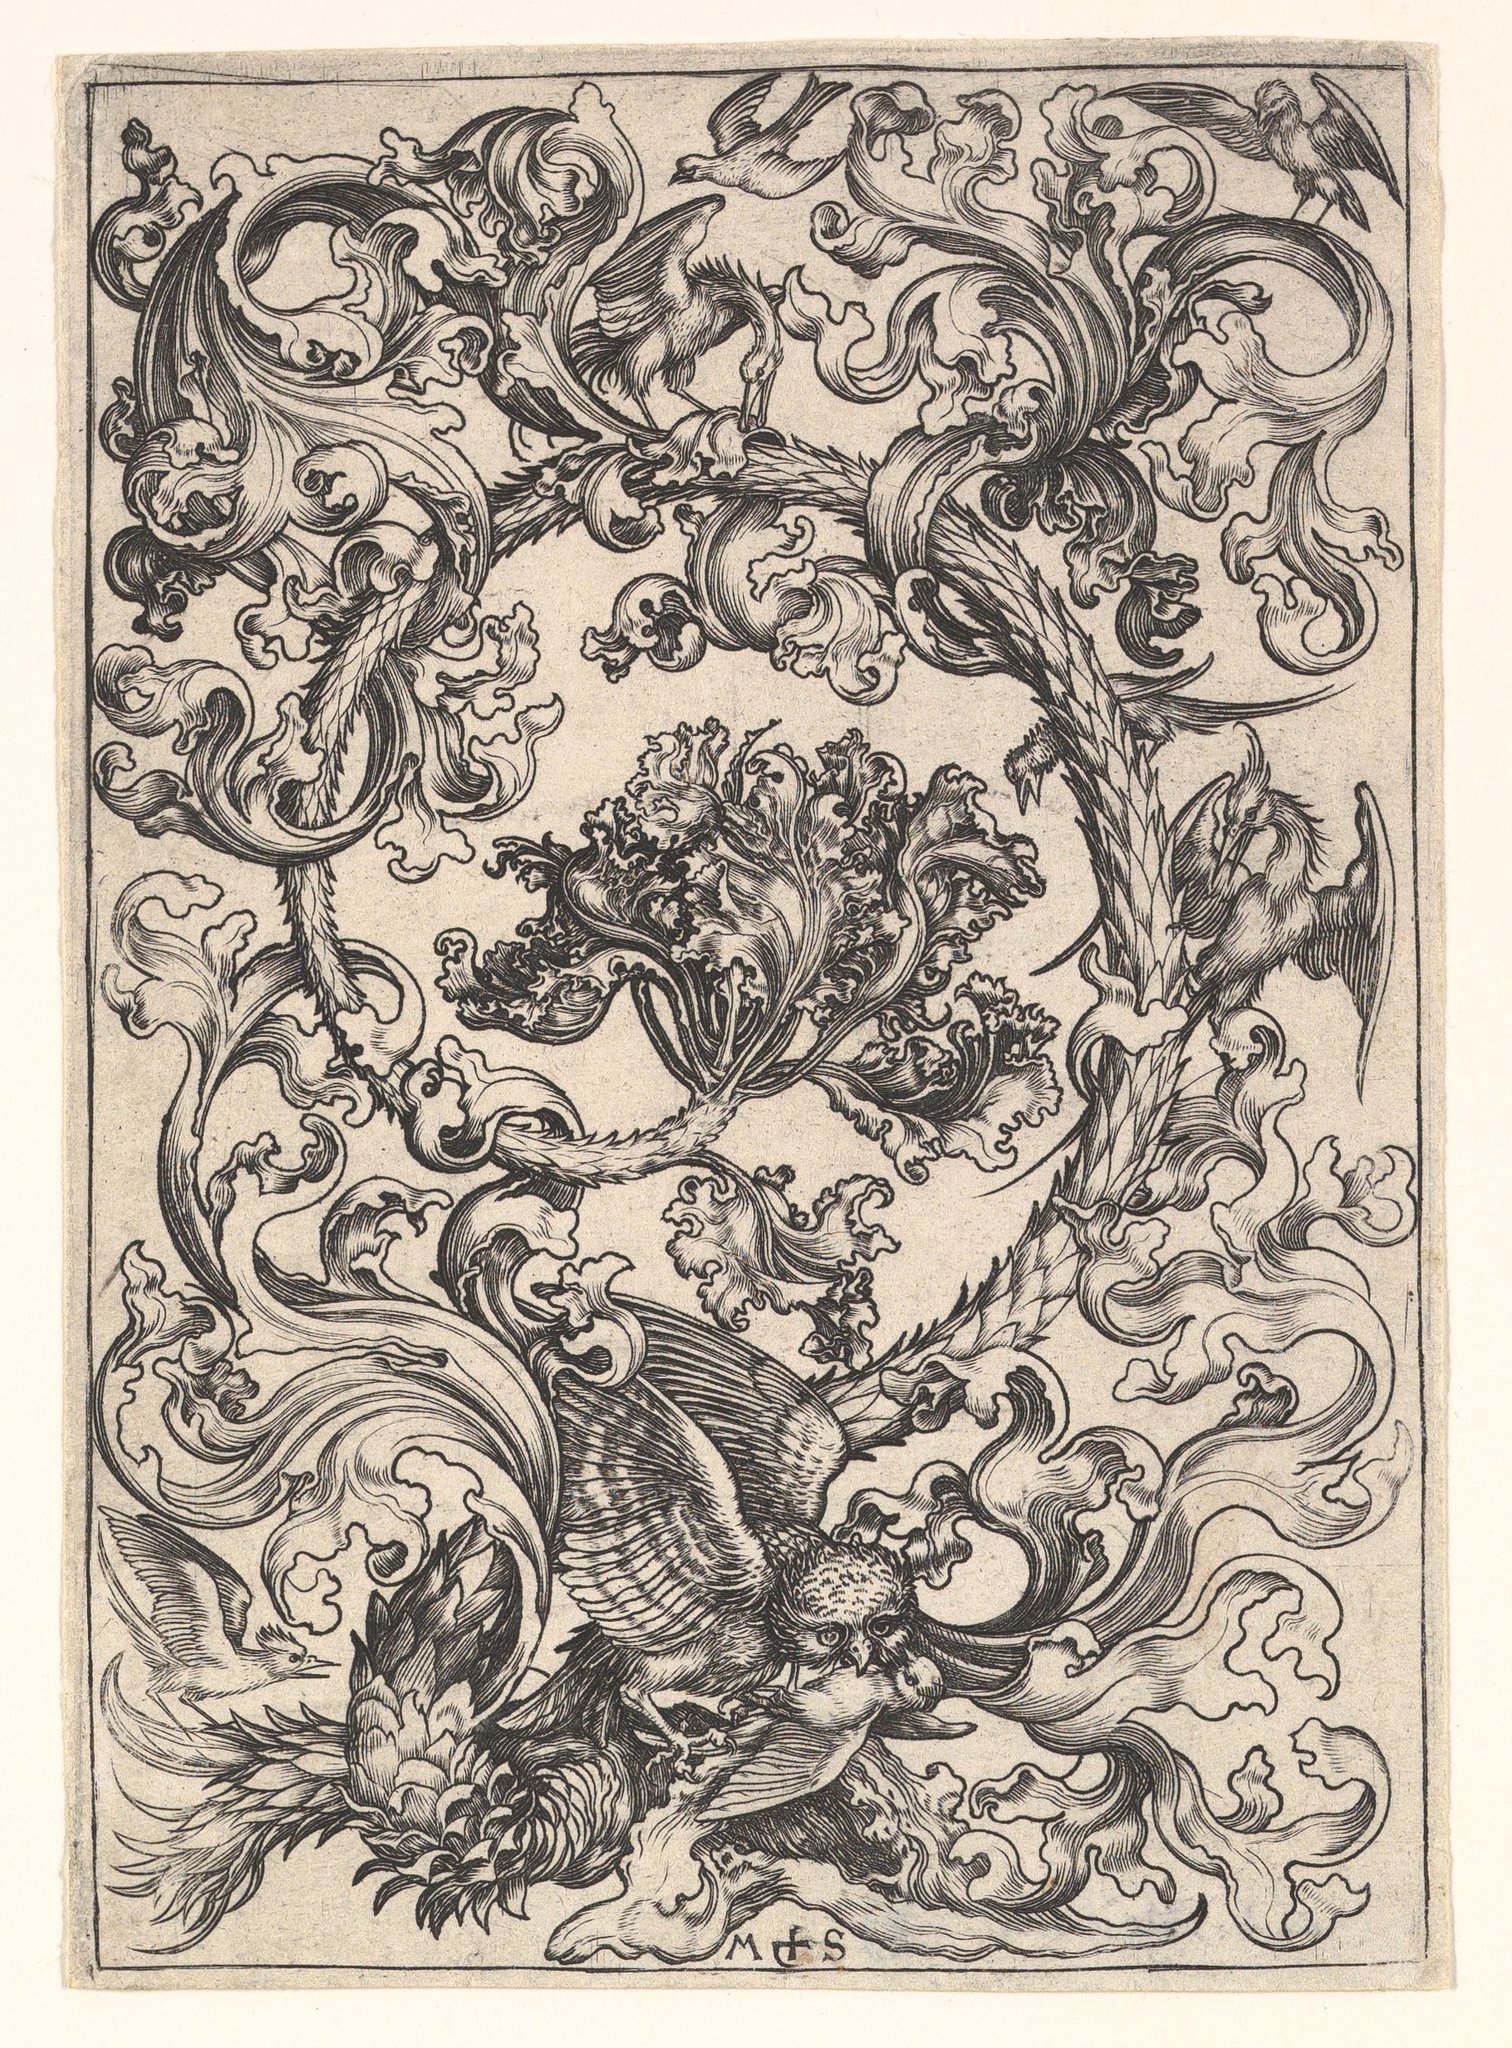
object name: collection ornament architecture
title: Ornament with Owl Mocked by Day Birds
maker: martin schongauer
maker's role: artist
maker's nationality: german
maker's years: 1430-1491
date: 1470-1491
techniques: engraving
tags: birds,ornament,owls